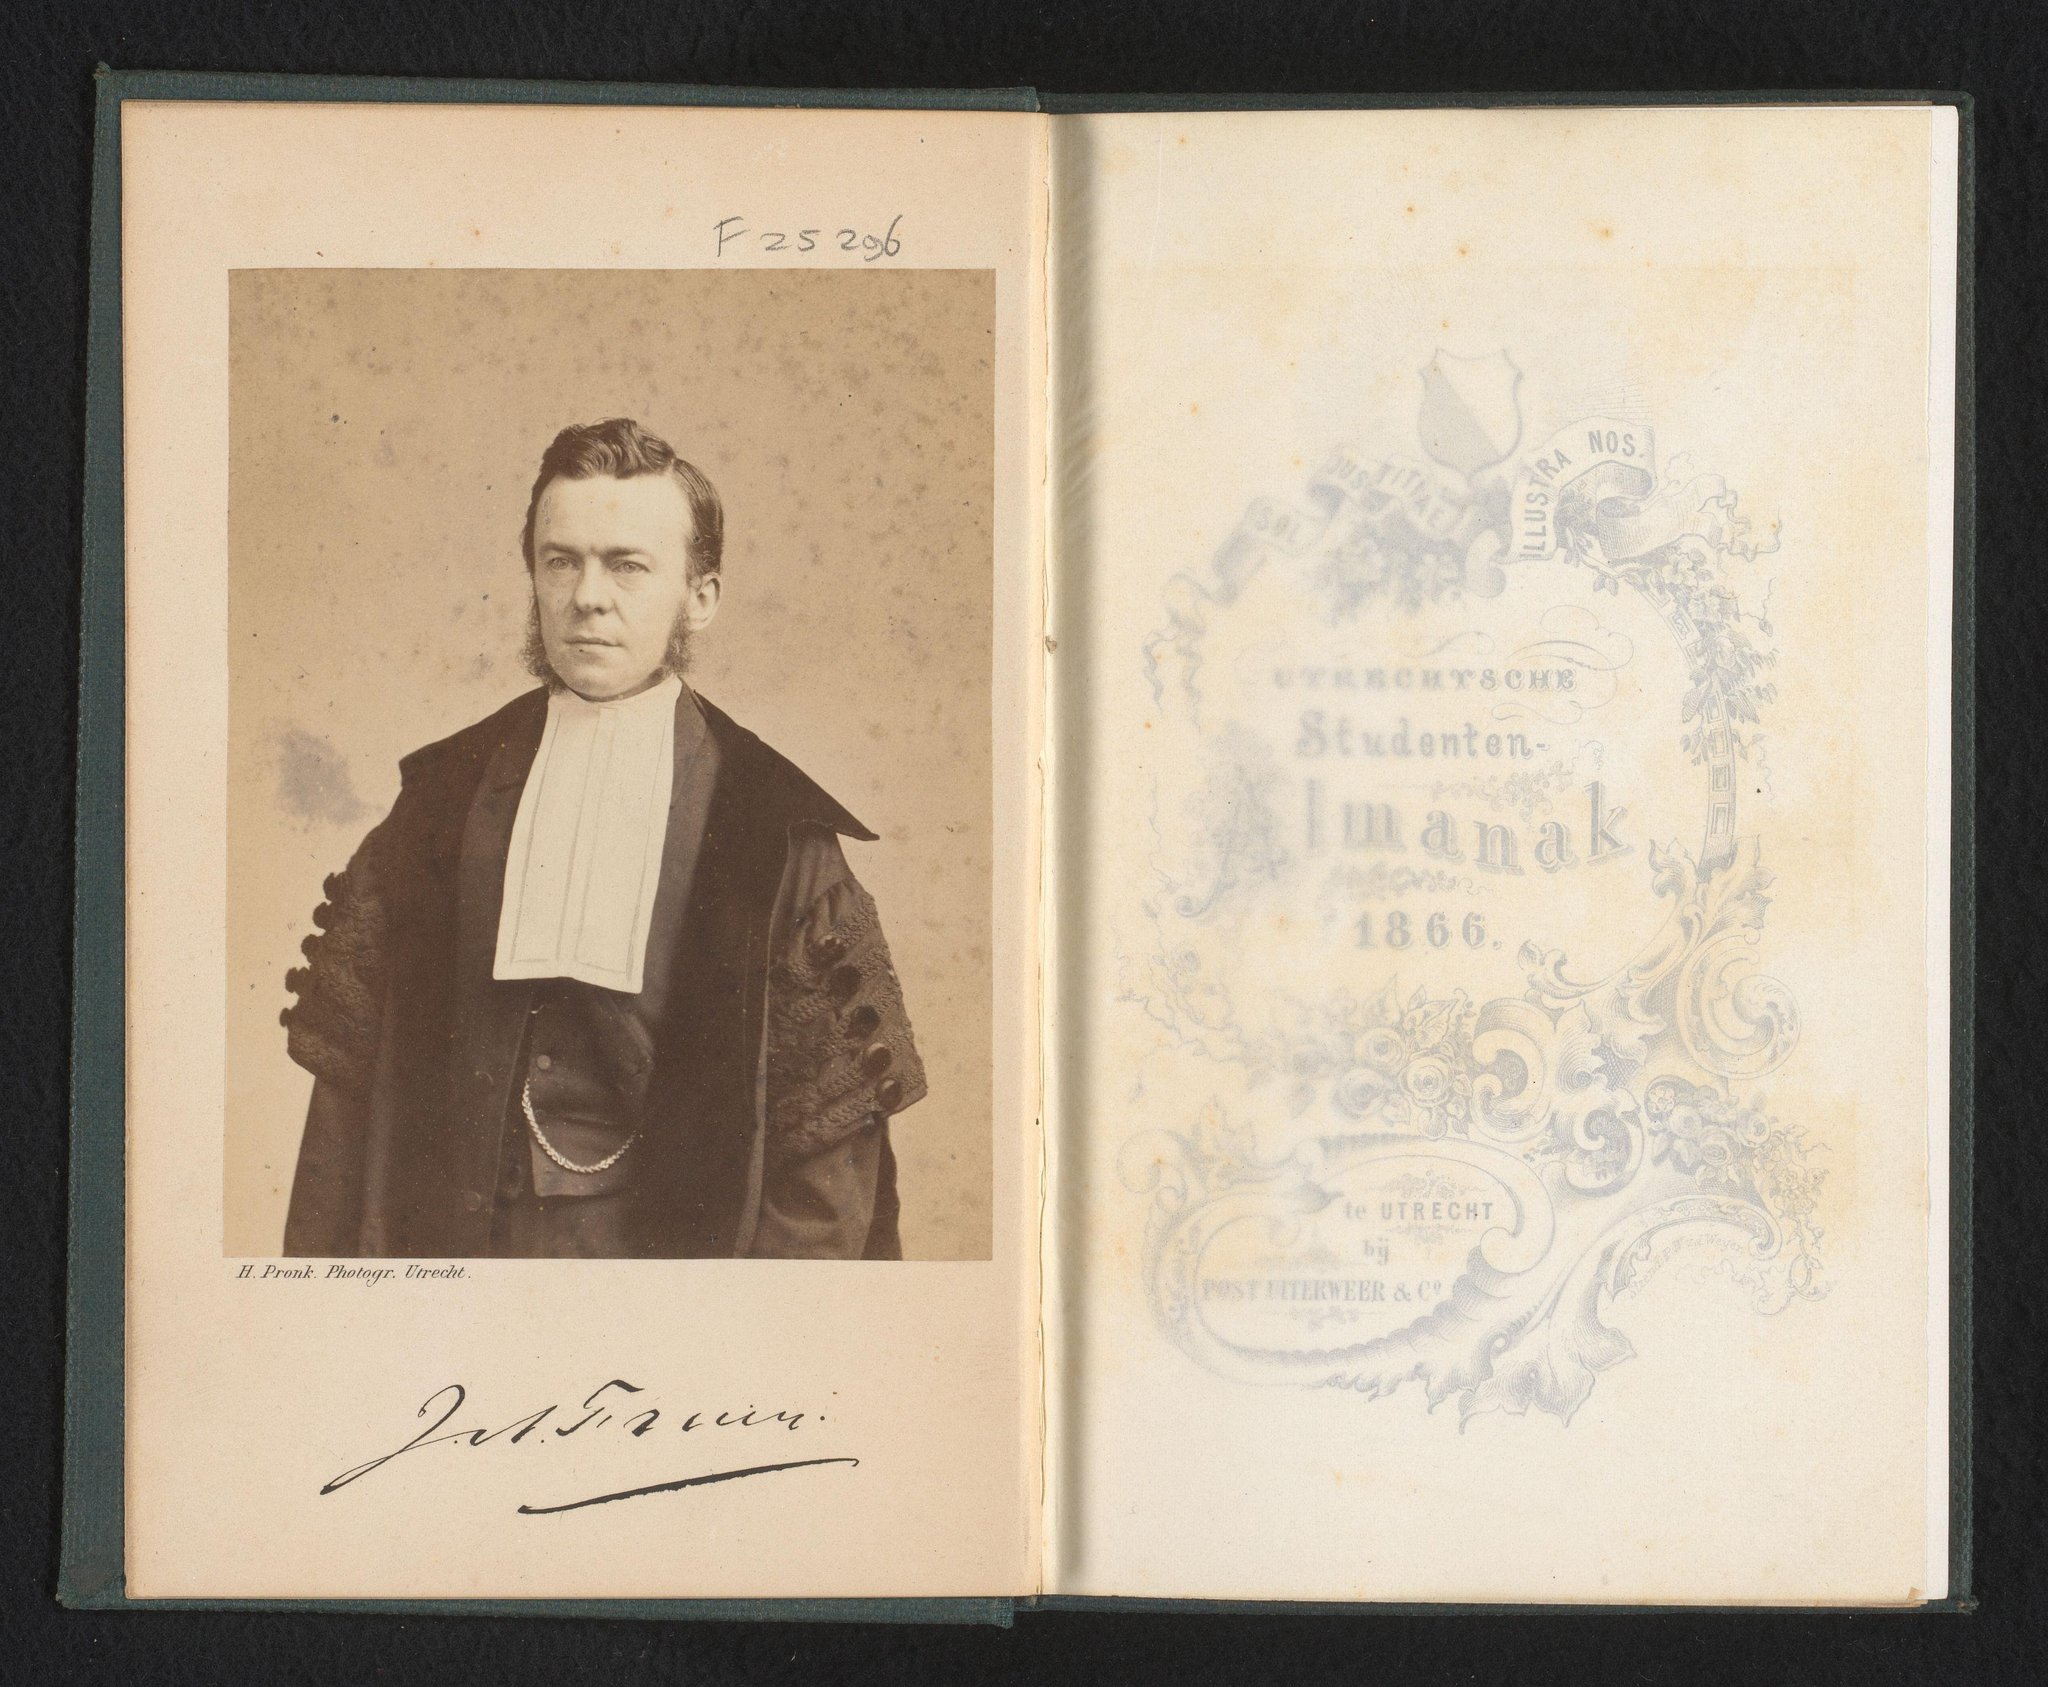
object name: photograph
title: Portret van J.A. Fruin, hoogleraar rechtsgeleerdheid en rector magnificus van de Universiteit Utrecht 1865-1866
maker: henri pronk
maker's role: fotograaf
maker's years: 1813-1893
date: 1864-1865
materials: paper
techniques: albumen print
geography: utrecht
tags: rotterdam, utrecht, historical persons, professor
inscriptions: signature: ‘JA Fruin’